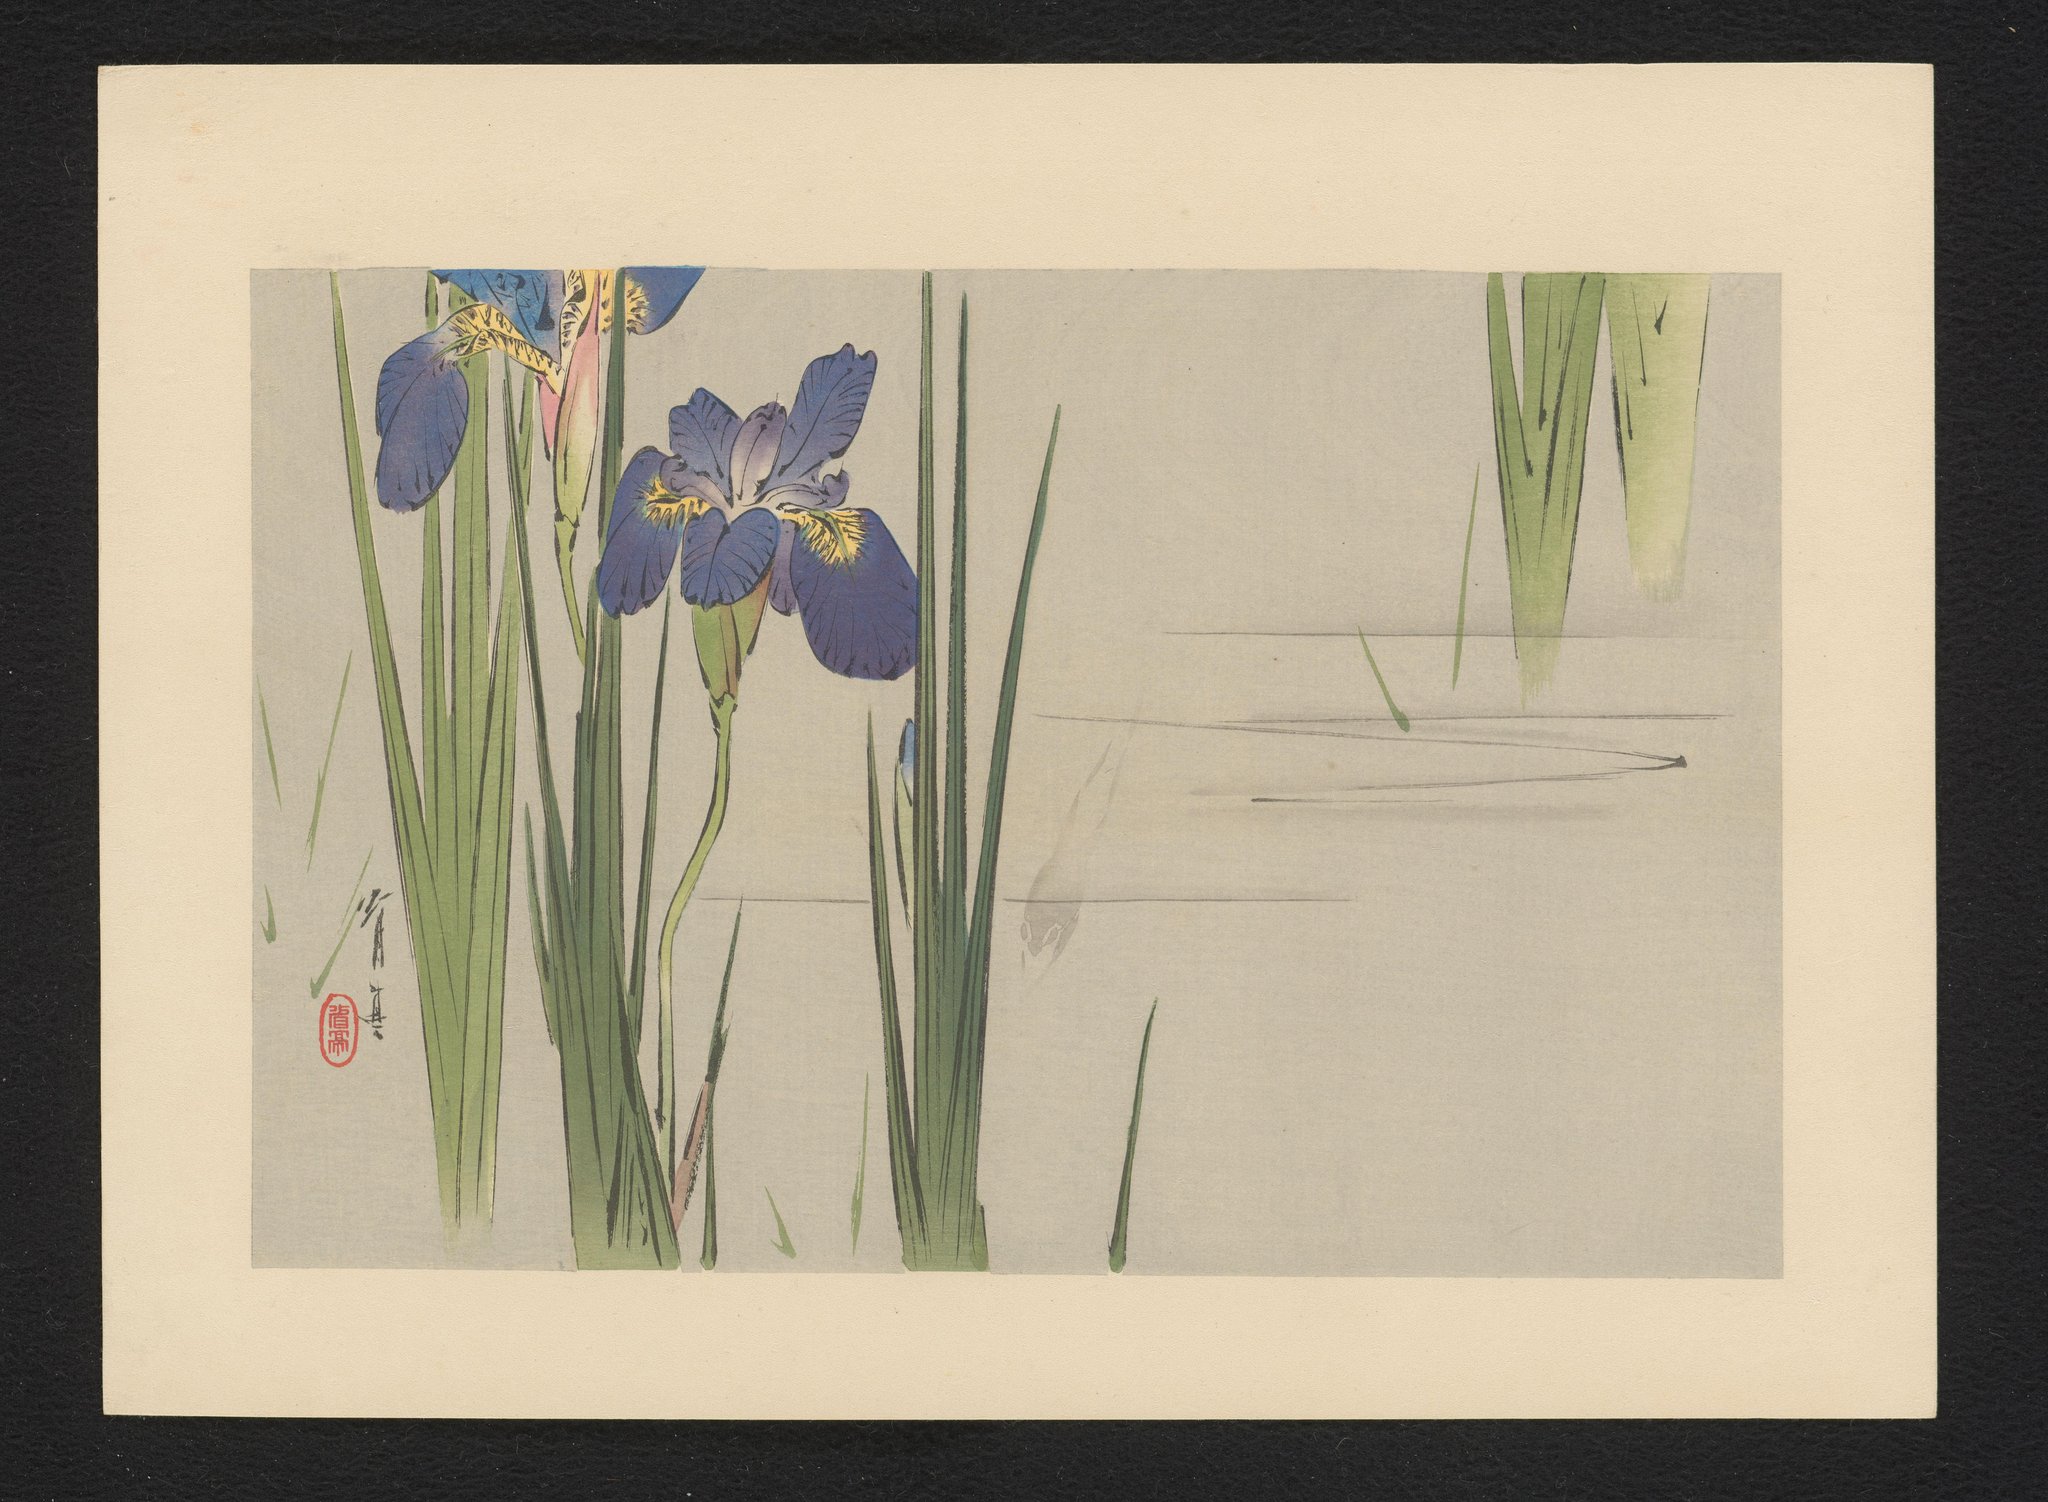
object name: print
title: Bloemen en vogels door Seitei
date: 1916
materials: paper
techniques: woodcut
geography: tokyo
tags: flowers